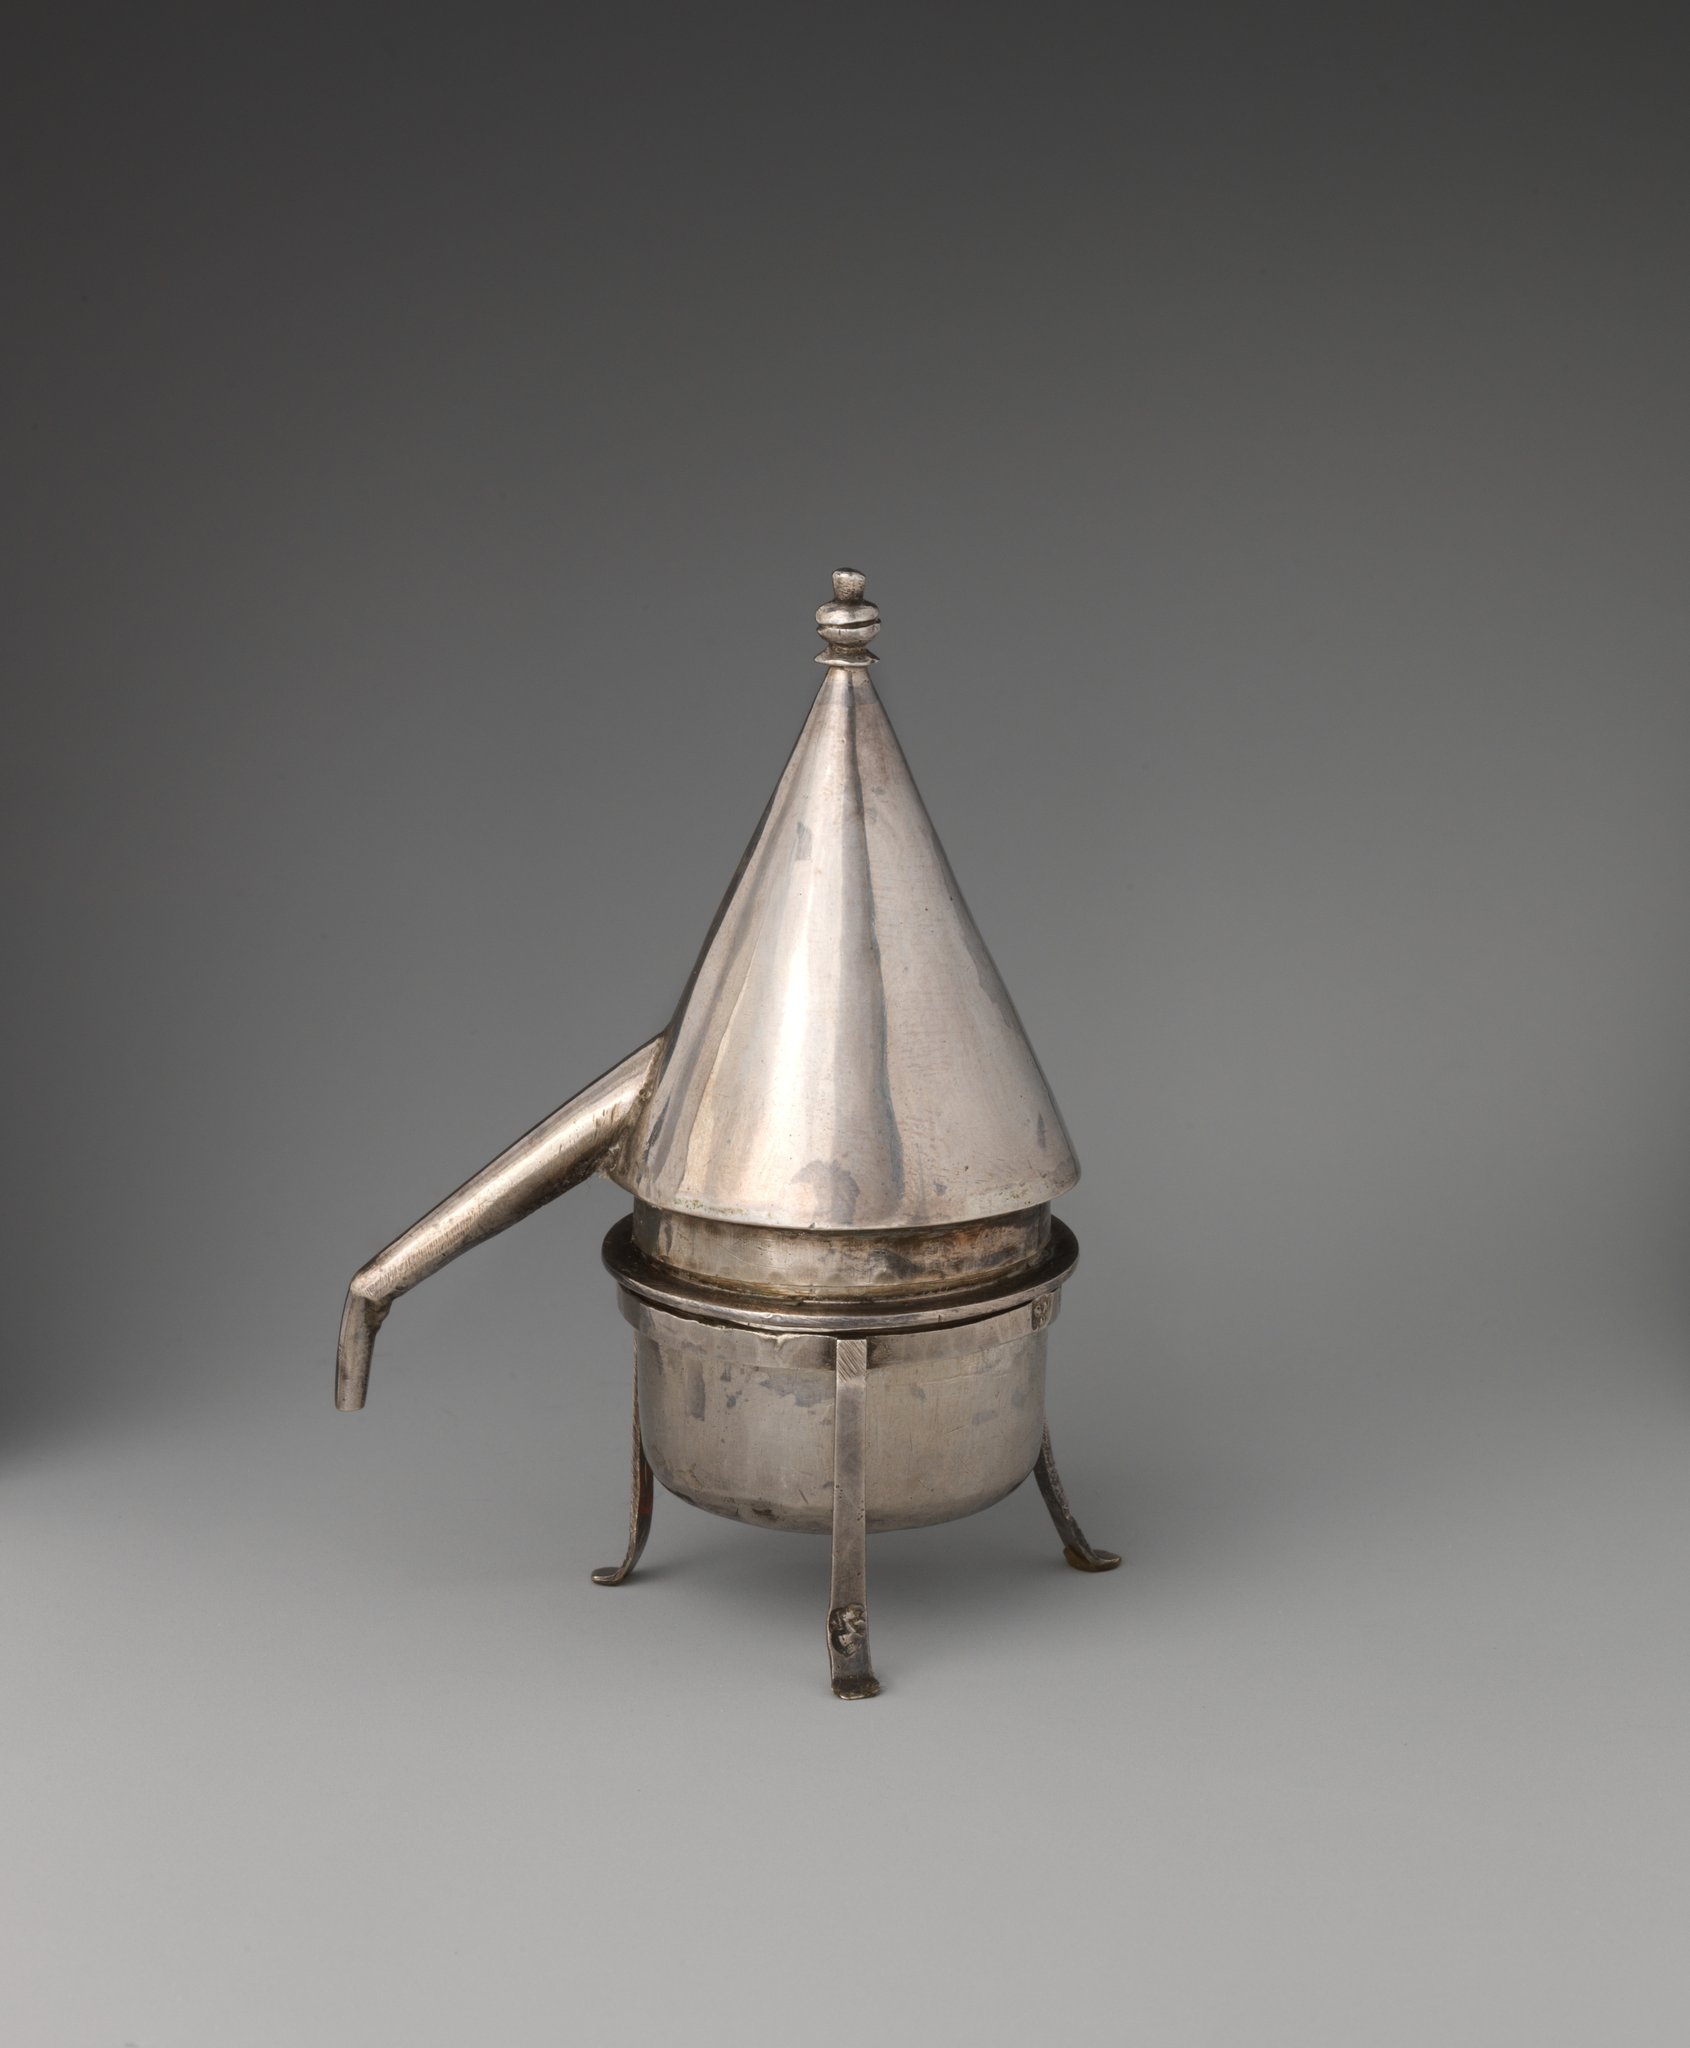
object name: whiskey still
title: Miniature whiskey still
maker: george manjoy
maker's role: maker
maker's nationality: british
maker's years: 1685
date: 1685-1686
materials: silver